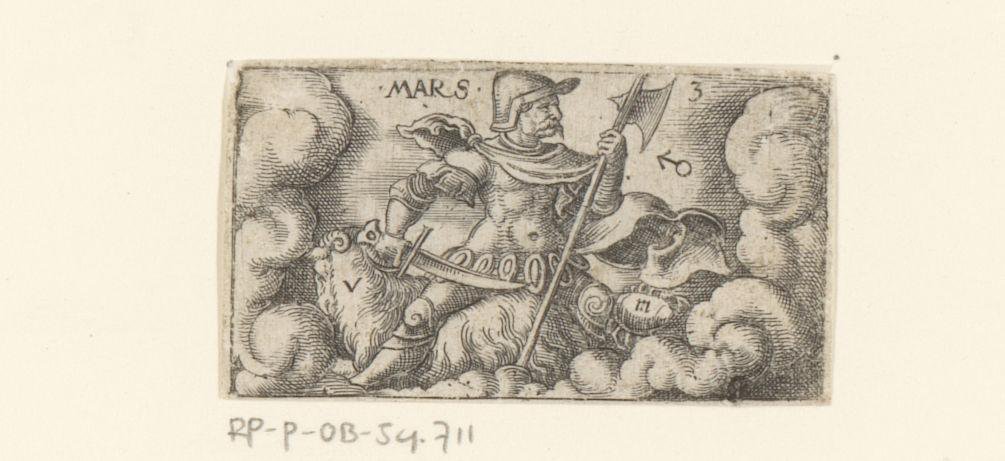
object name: print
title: Personificaties van zeven planeten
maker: virgilius solis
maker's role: draughtsman, print maker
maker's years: 1514-1562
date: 1524-1562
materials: paper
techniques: etching, intaglio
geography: nuremberg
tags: (story of) mars (ares), clouds, mars (planet)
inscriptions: collector's mark: Lugt 2228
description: Maakt deel uit van een serie die bestaat uit vier prenten met zeven personificaties van planeten en een cartouche met titel.